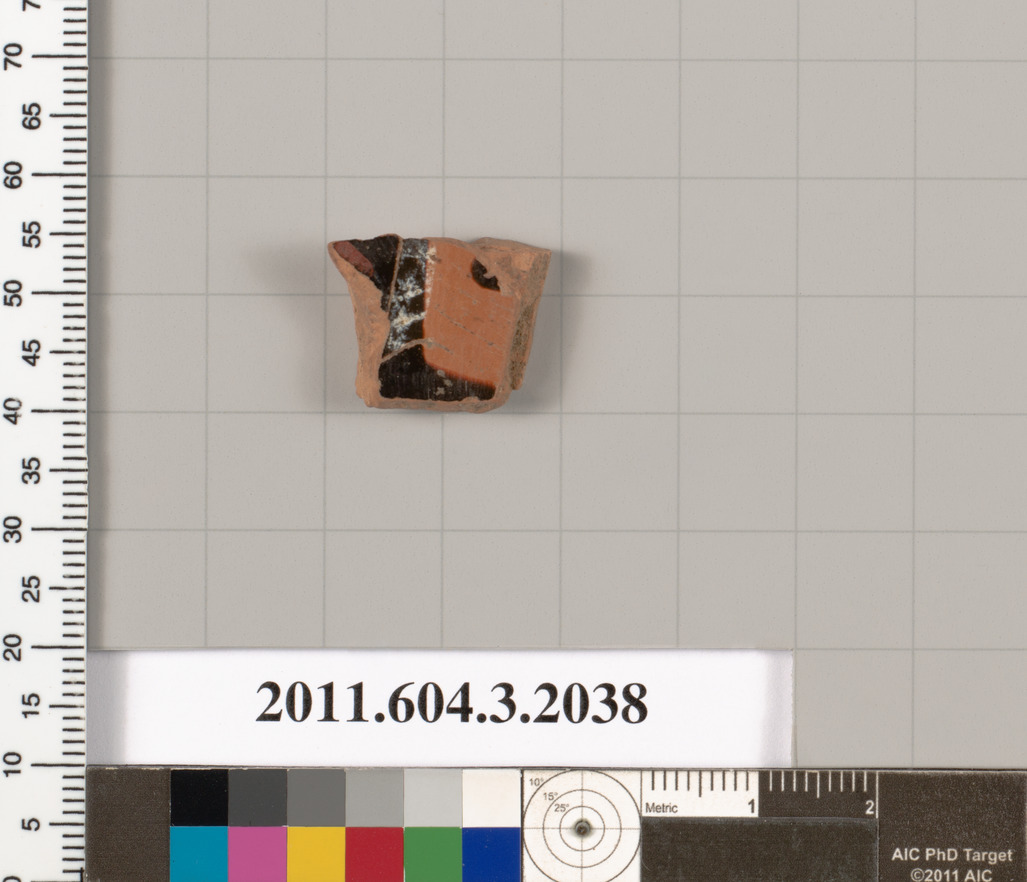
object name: kylix fragment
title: Terracotta fragment of a kylix (drinking cup)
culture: greek, attic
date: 500-468 BCE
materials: terracotta